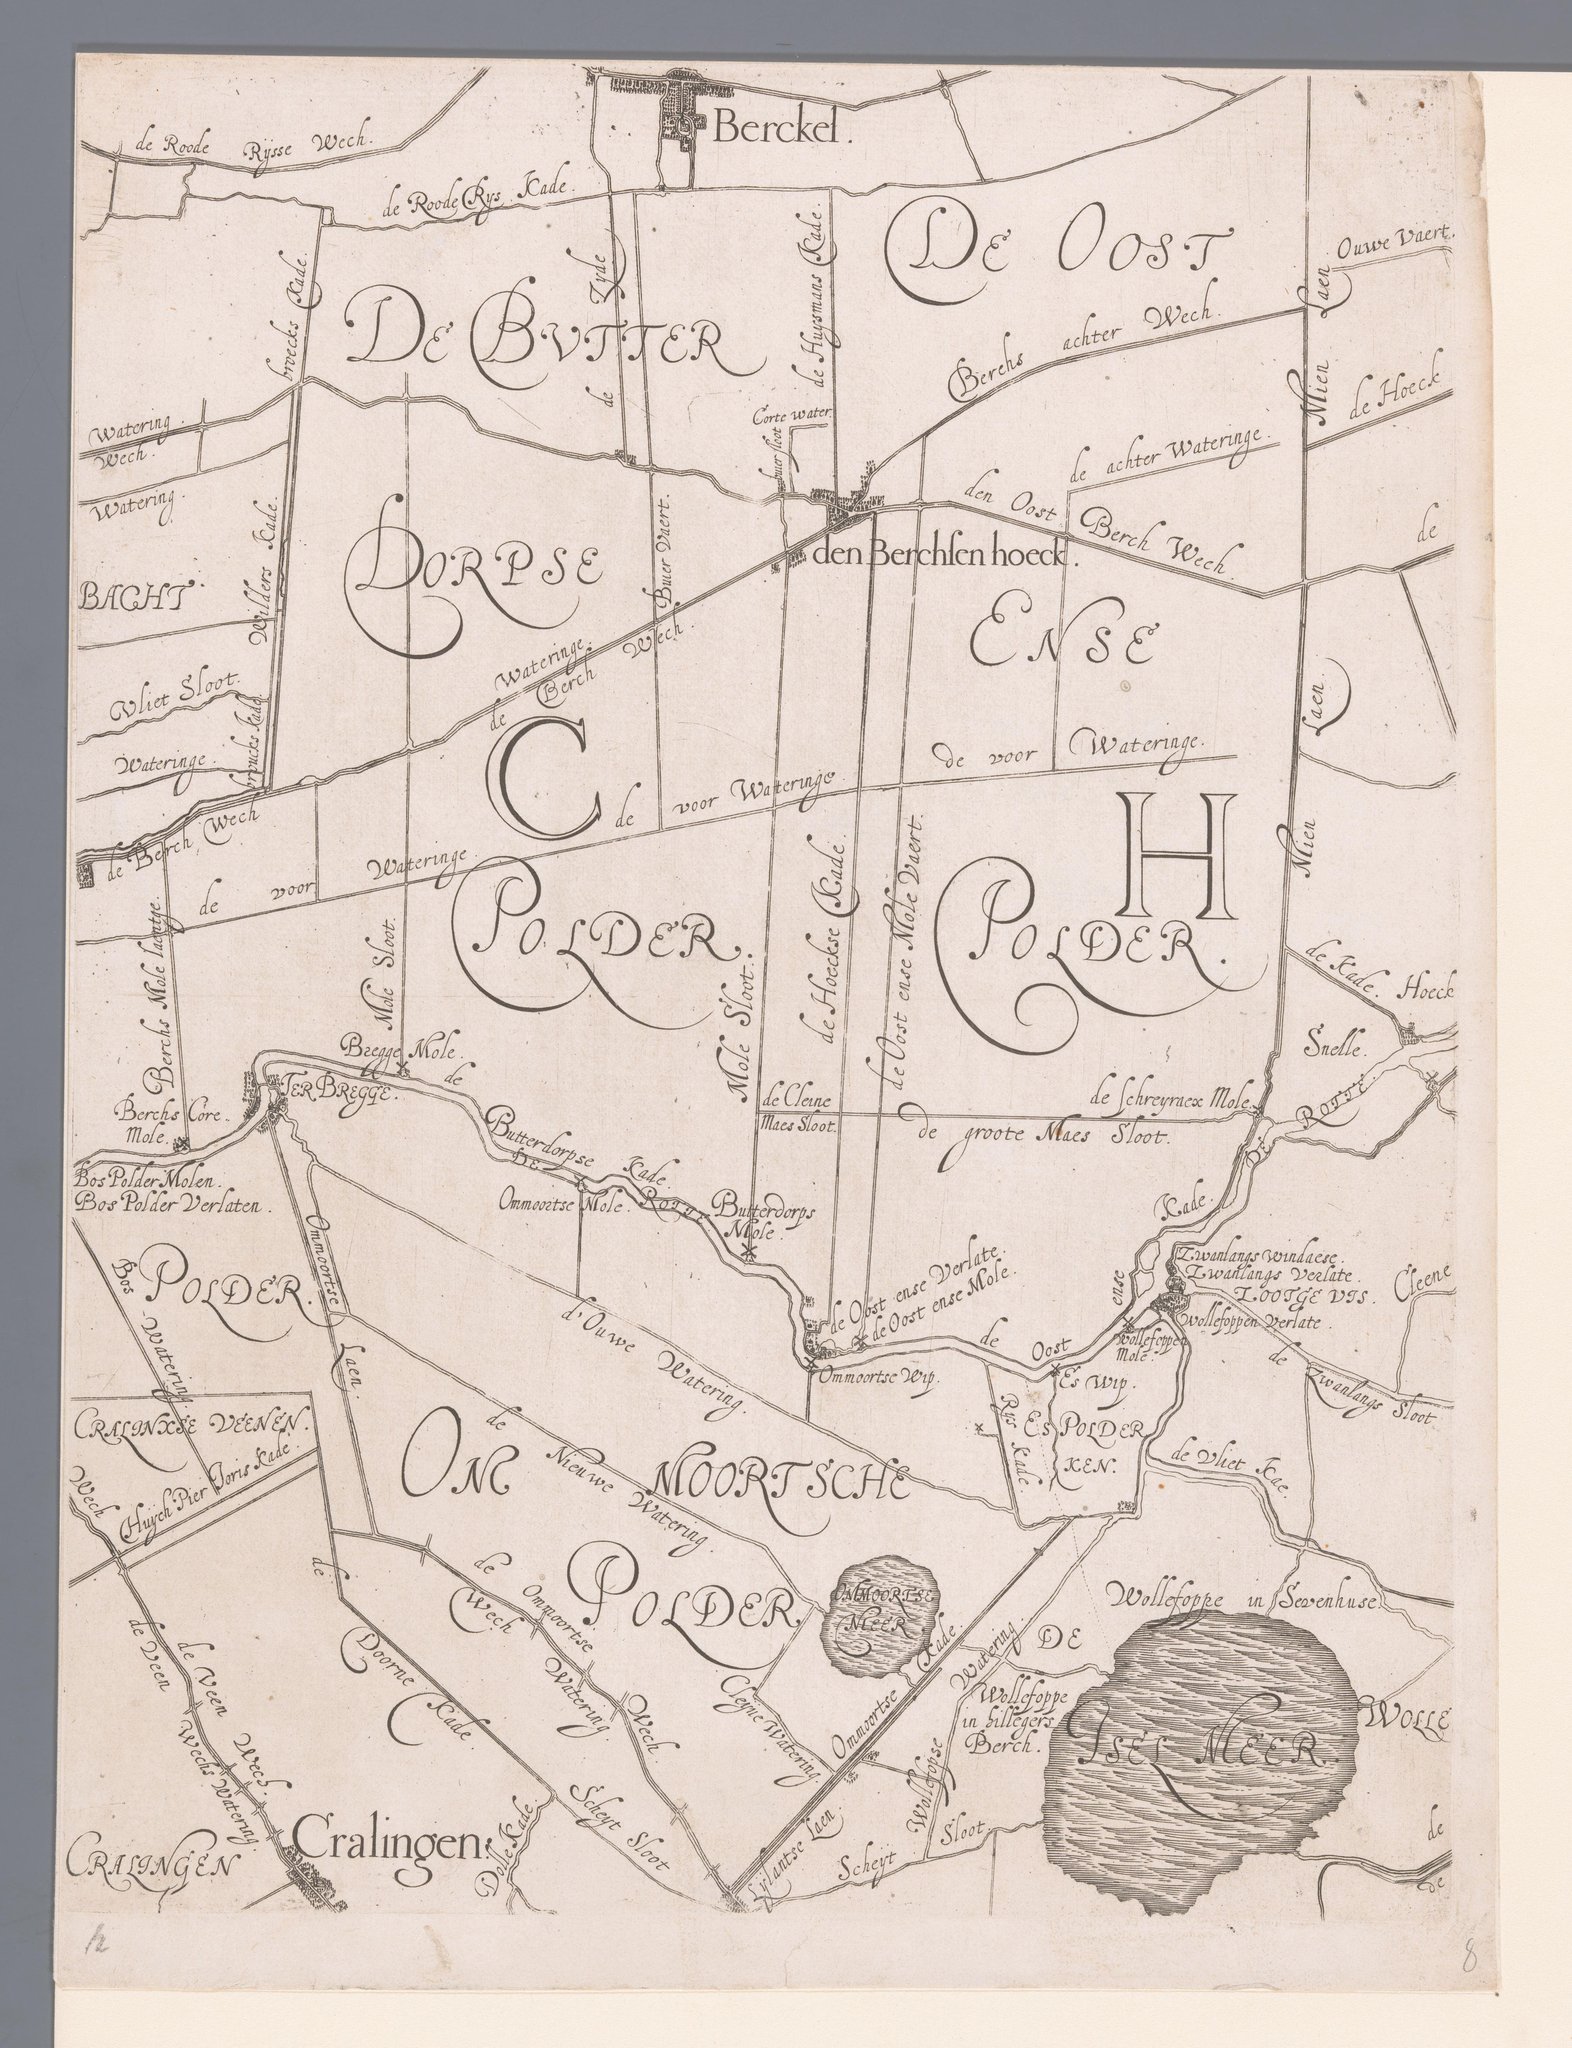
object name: print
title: Kaart van het Hoogheemraadschap van Schieland, met Berkel en Bergschenhoek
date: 1611-1635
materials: paper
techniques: engraving, etching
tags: maps of separate countries or regions, armorial bearing, heraldry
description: Deze kaart is tussen 1611 en 1635 vijf keer uitgegeven zonder dat de platen zijn bijgewerkt. Onduidelijk tot welke uitgave dit exemplaar behoort.